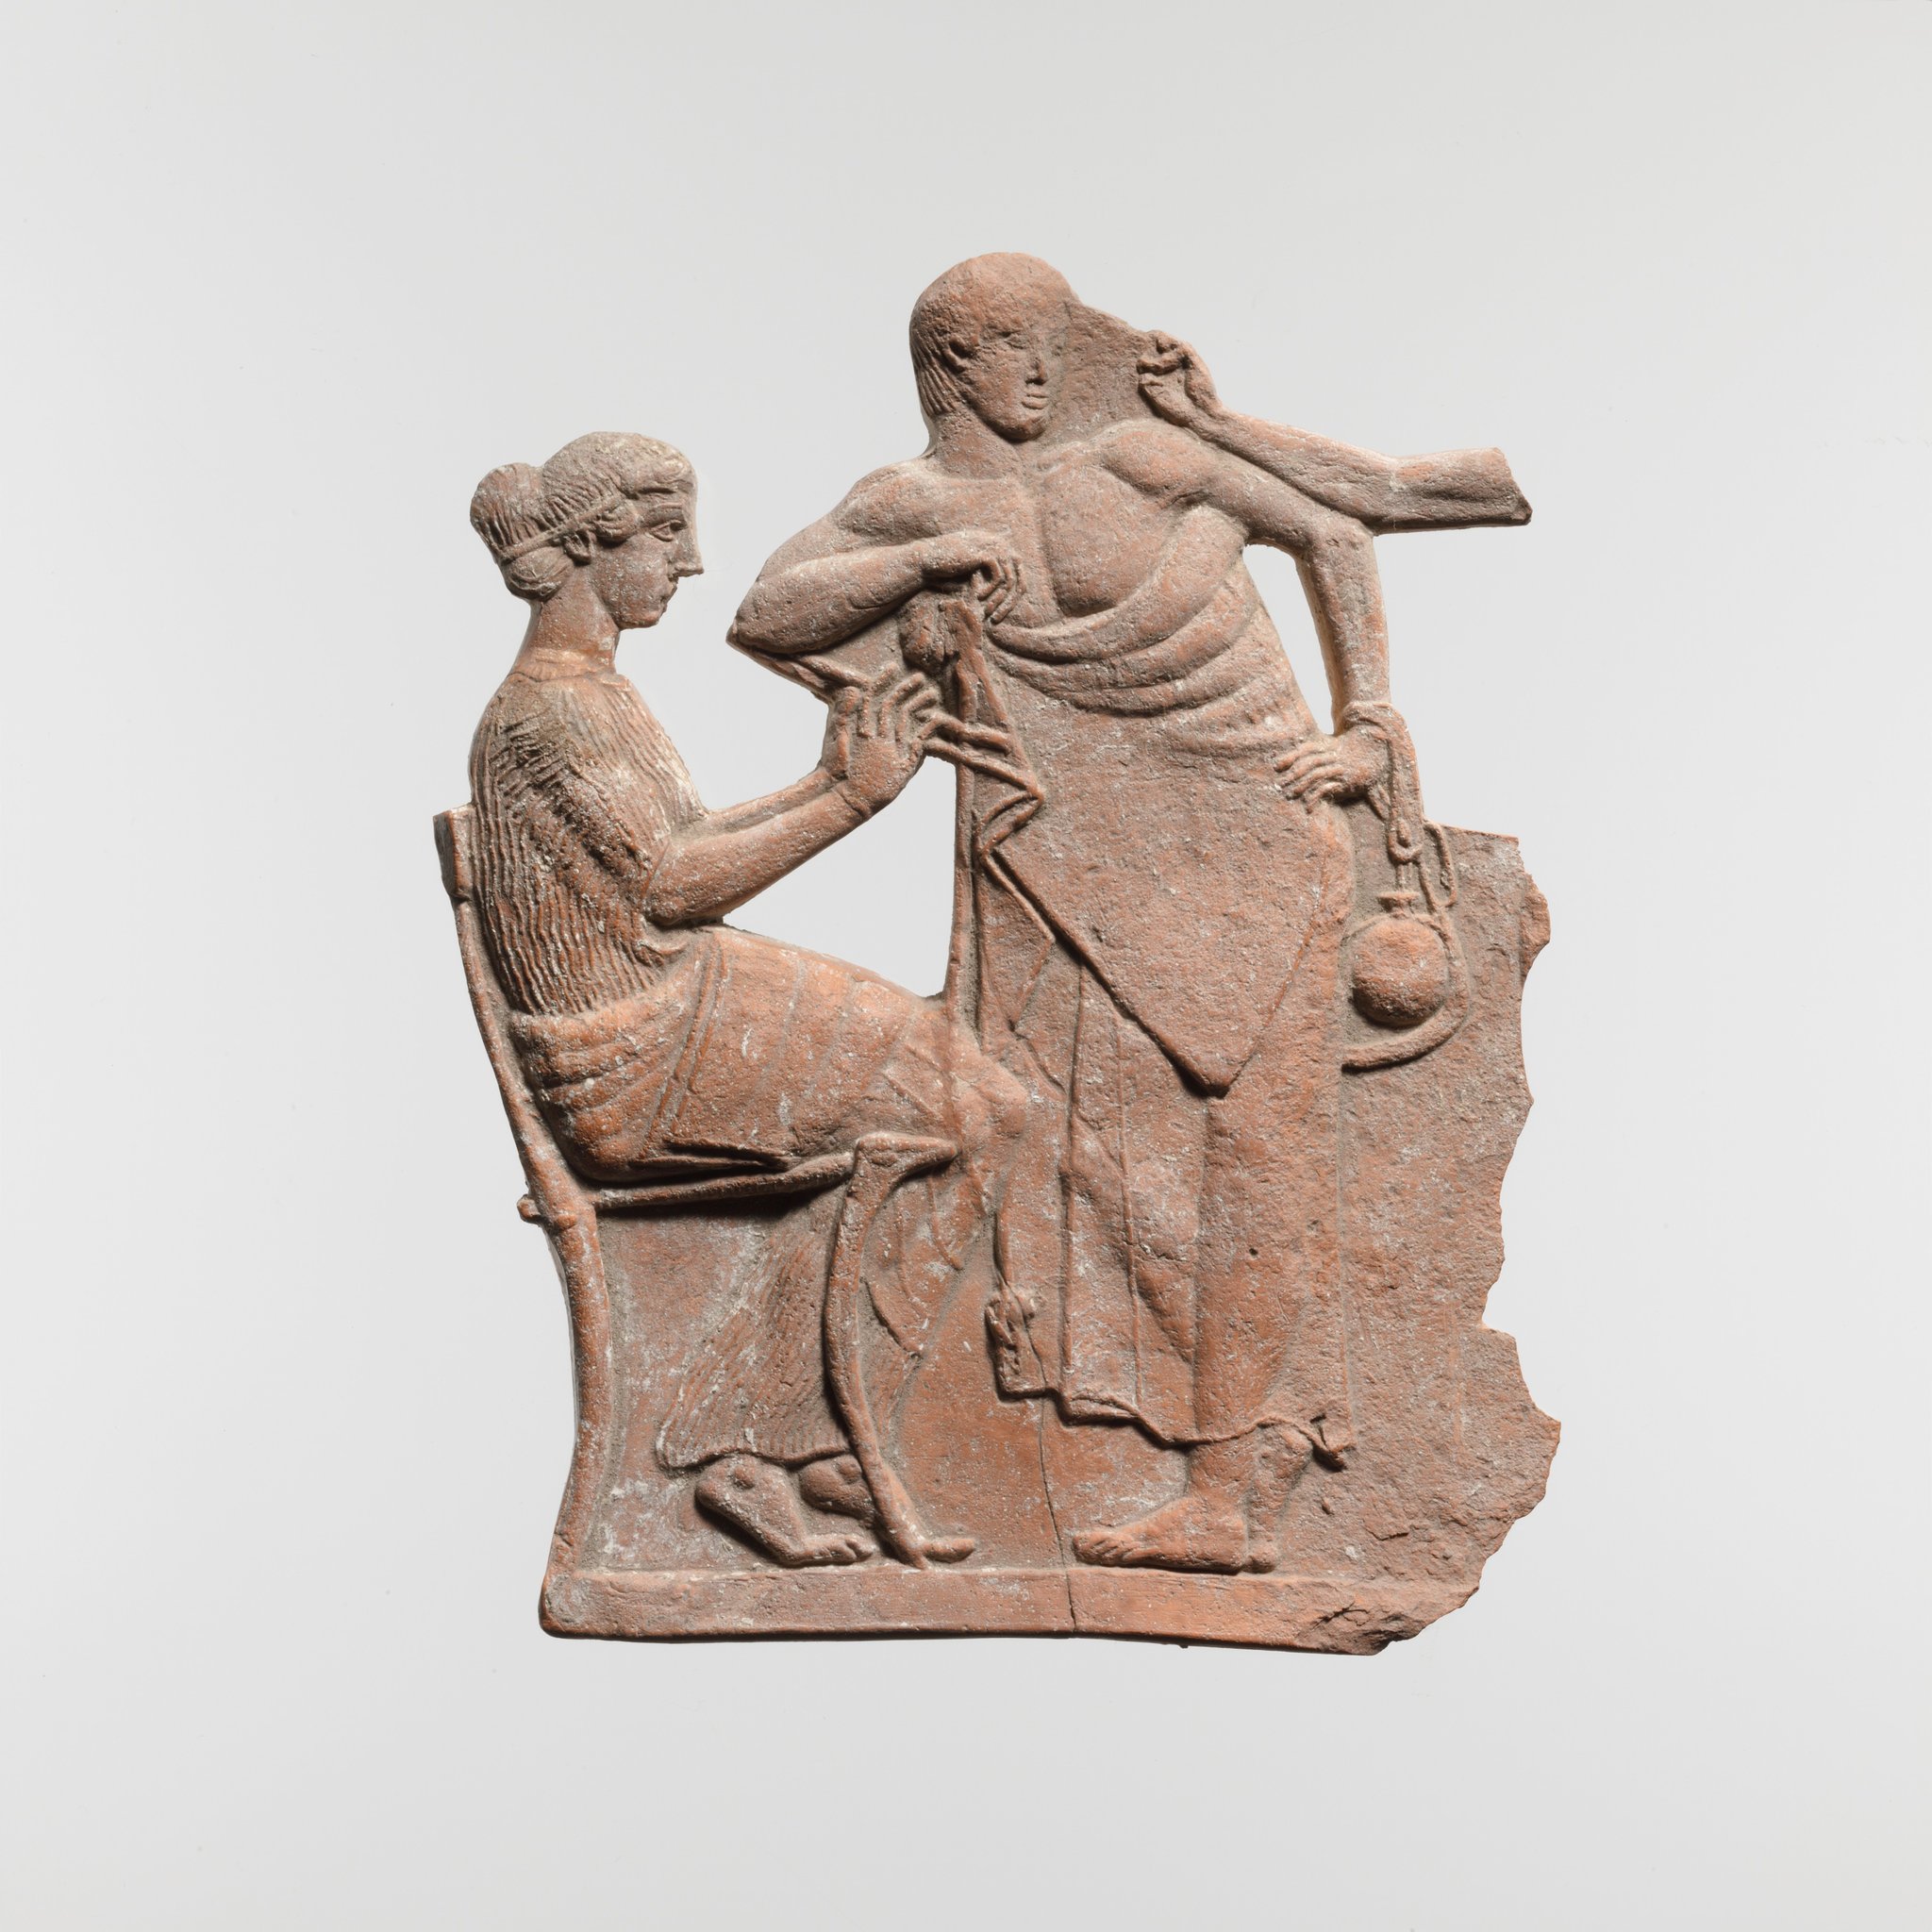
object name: relief of a woman playing flute and man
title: Terracotta relief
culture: greek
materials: terracotta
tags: men,women,flutes,musicians